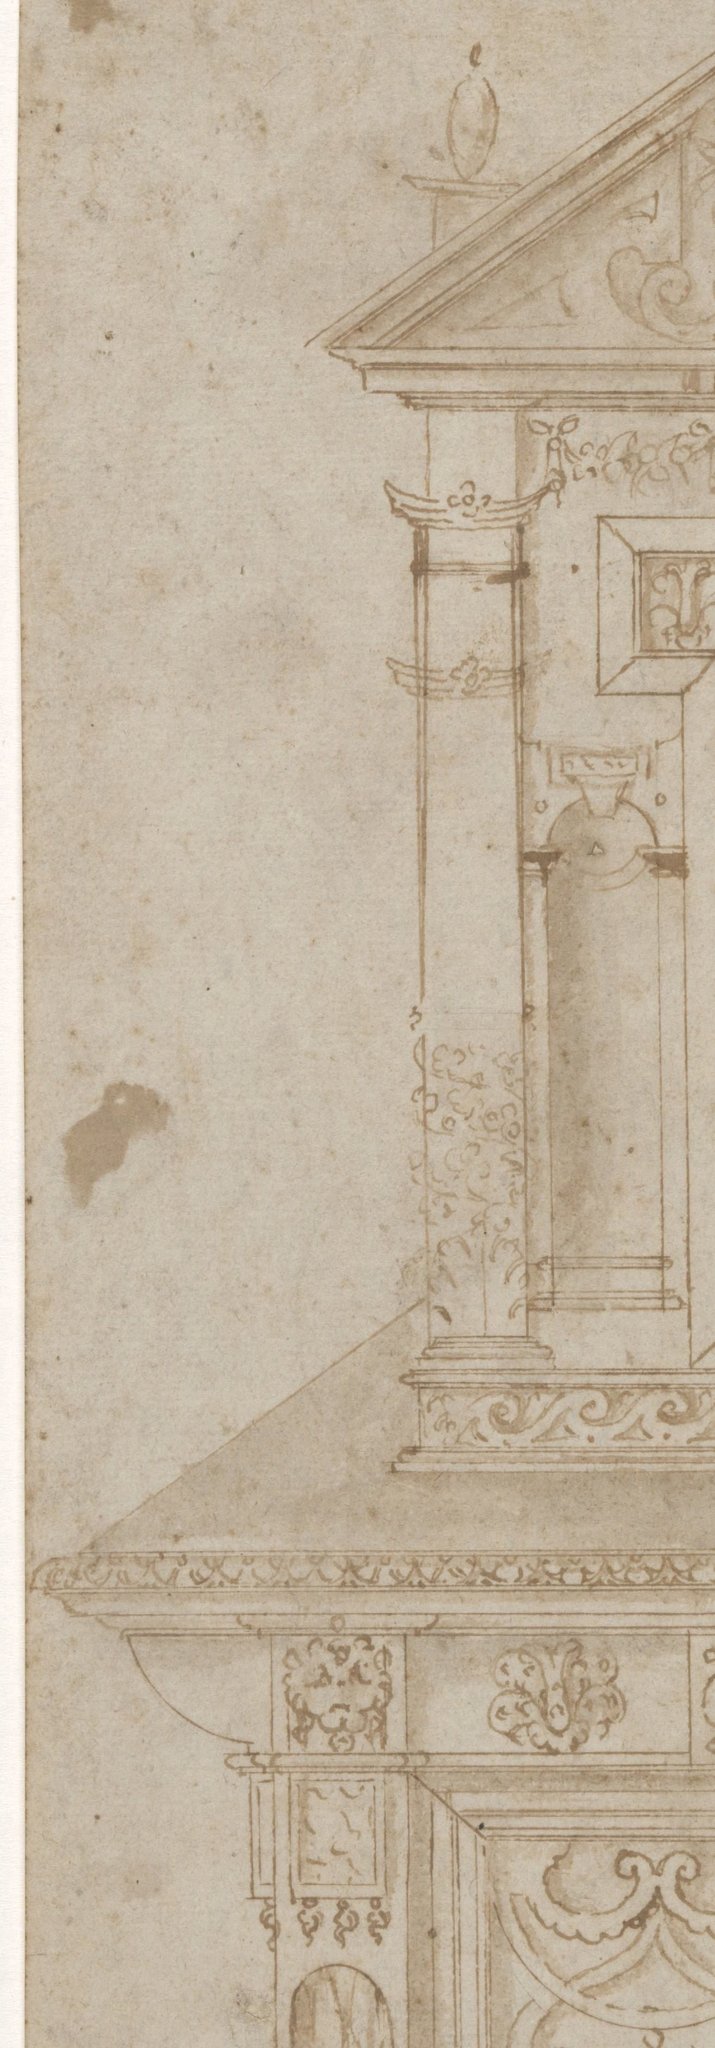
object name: design drawing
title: Ontwerp voor een met marmeren plaatjes ingelegde, met beeldhouwwerk versierde kast (linkerhelft)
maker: Anonymous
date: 1570-1600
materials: ink, paper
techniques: brush, pen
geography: paris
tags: ornamental cupboard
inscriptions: collector's mark: Lugt 175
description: Linkerhelft van een ontwerp voor een met marmeren plaatjes ingelegde, met beeldhouwwerk versierde kast.